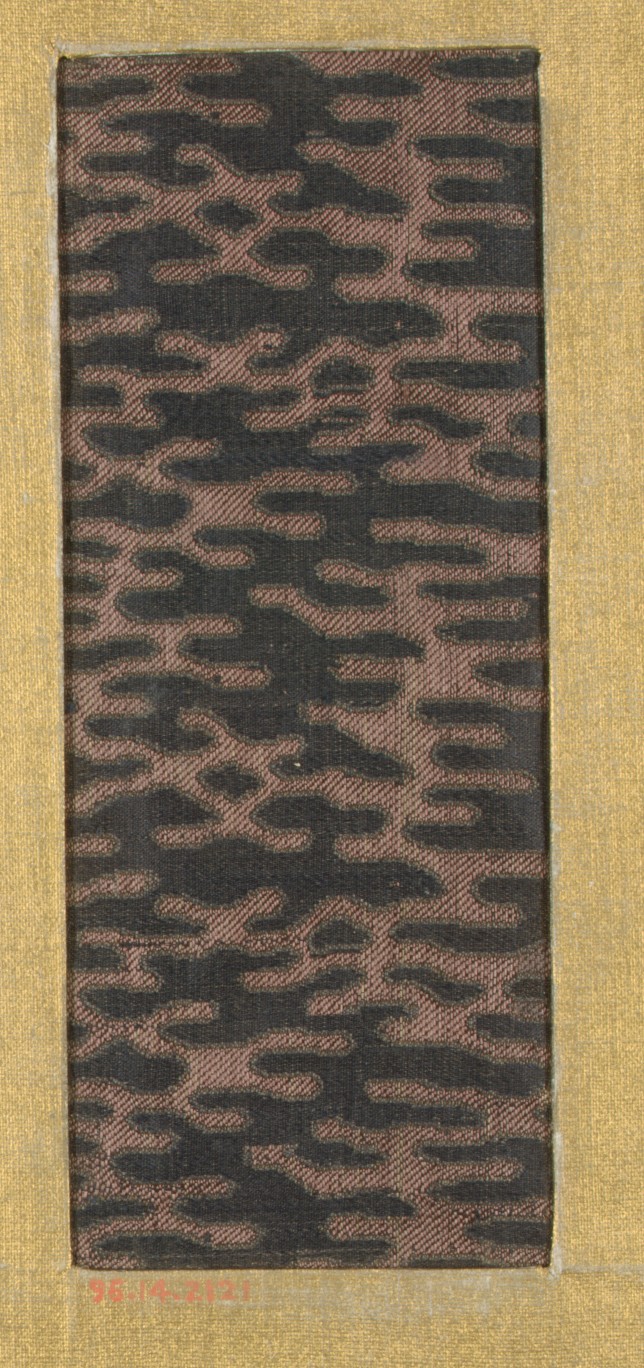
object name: piece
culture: japanese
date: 1701-1900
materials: silk